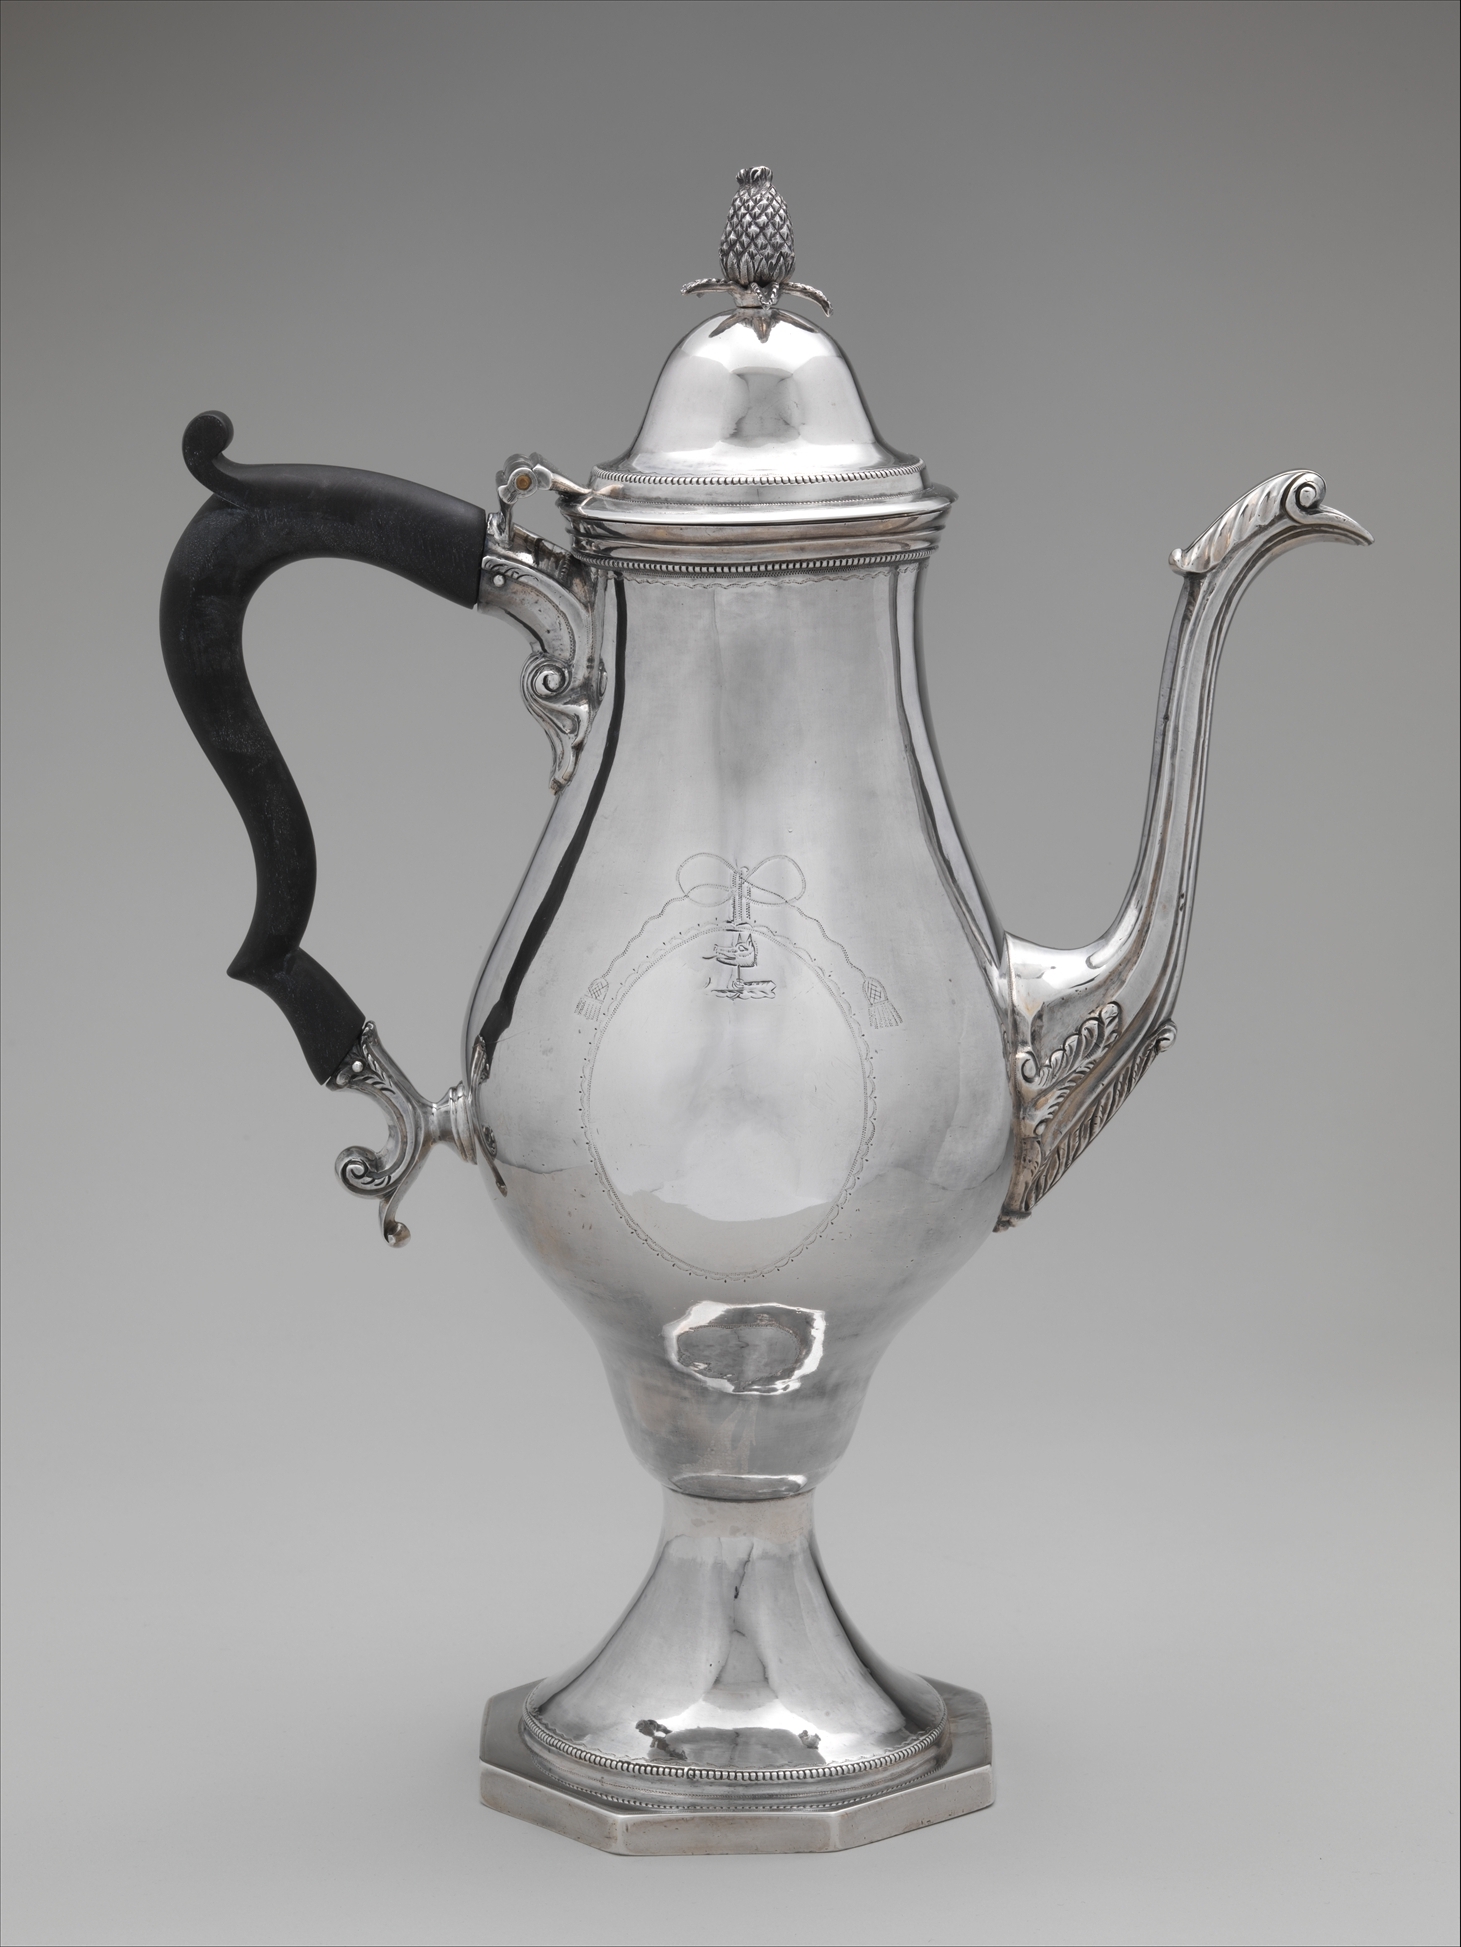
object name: coffeepot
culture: american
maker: charles faris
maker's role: maker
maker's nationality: american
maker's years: 1764-1800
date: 1790-1800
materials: silver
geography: united states